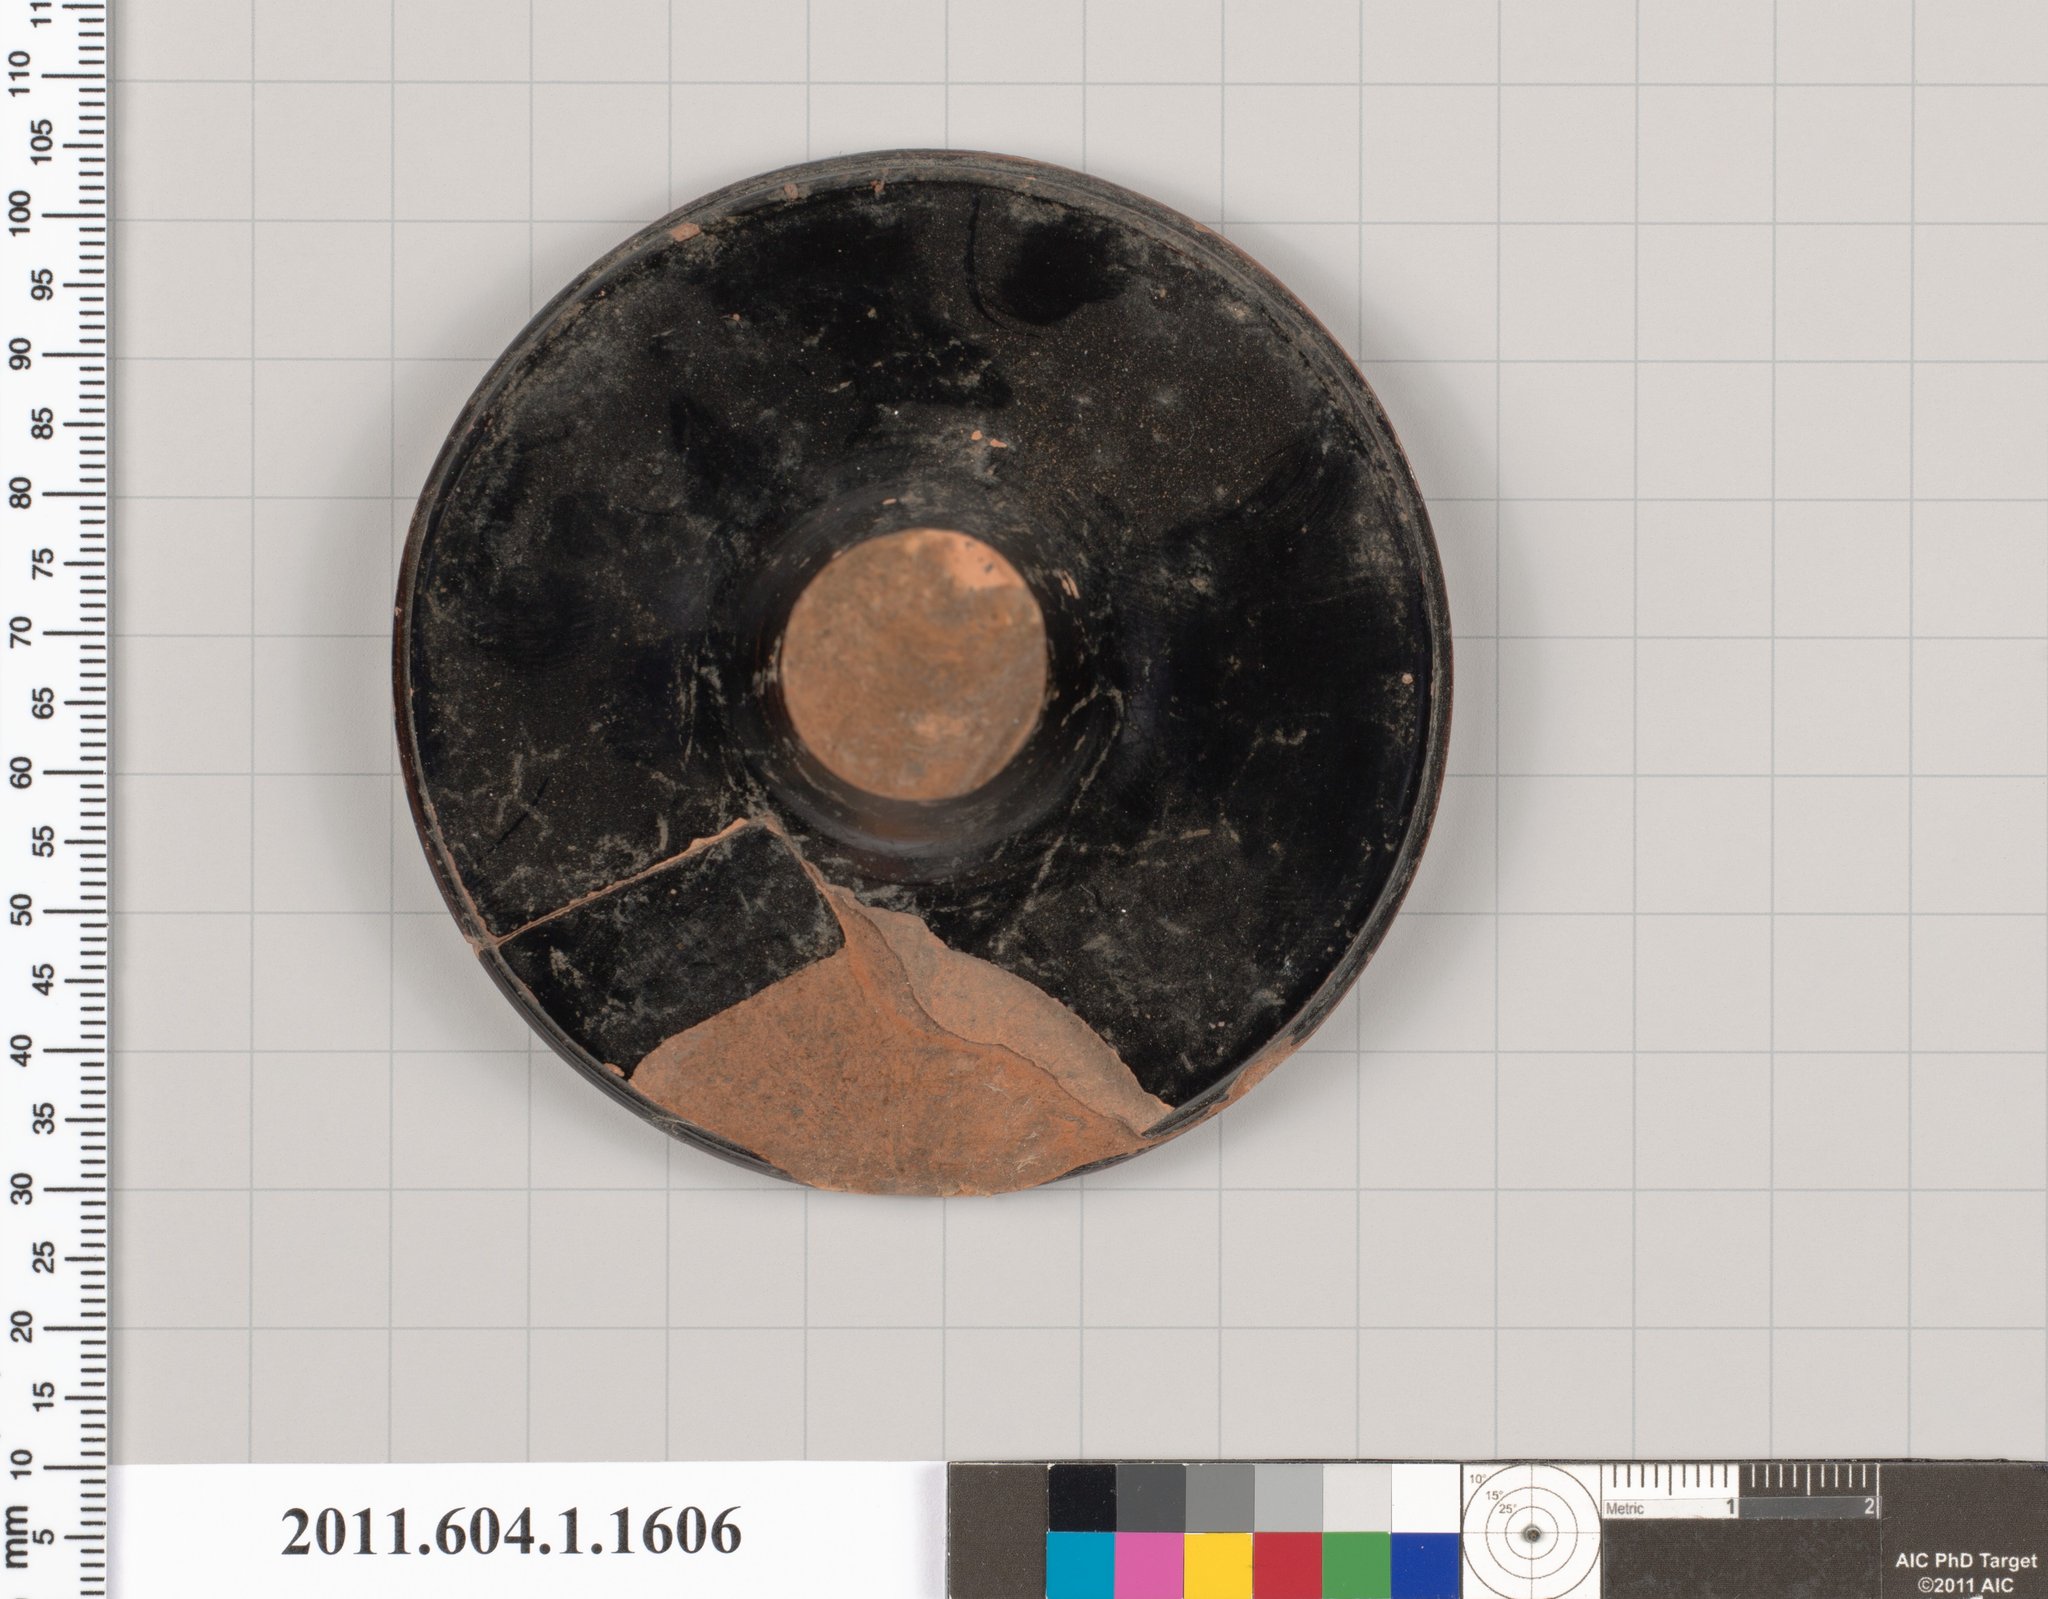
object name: kylix fragment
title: Terracotta fragment of a kylix (drinking cup)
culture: greek, attic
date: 500-401 BCE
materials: terracotta